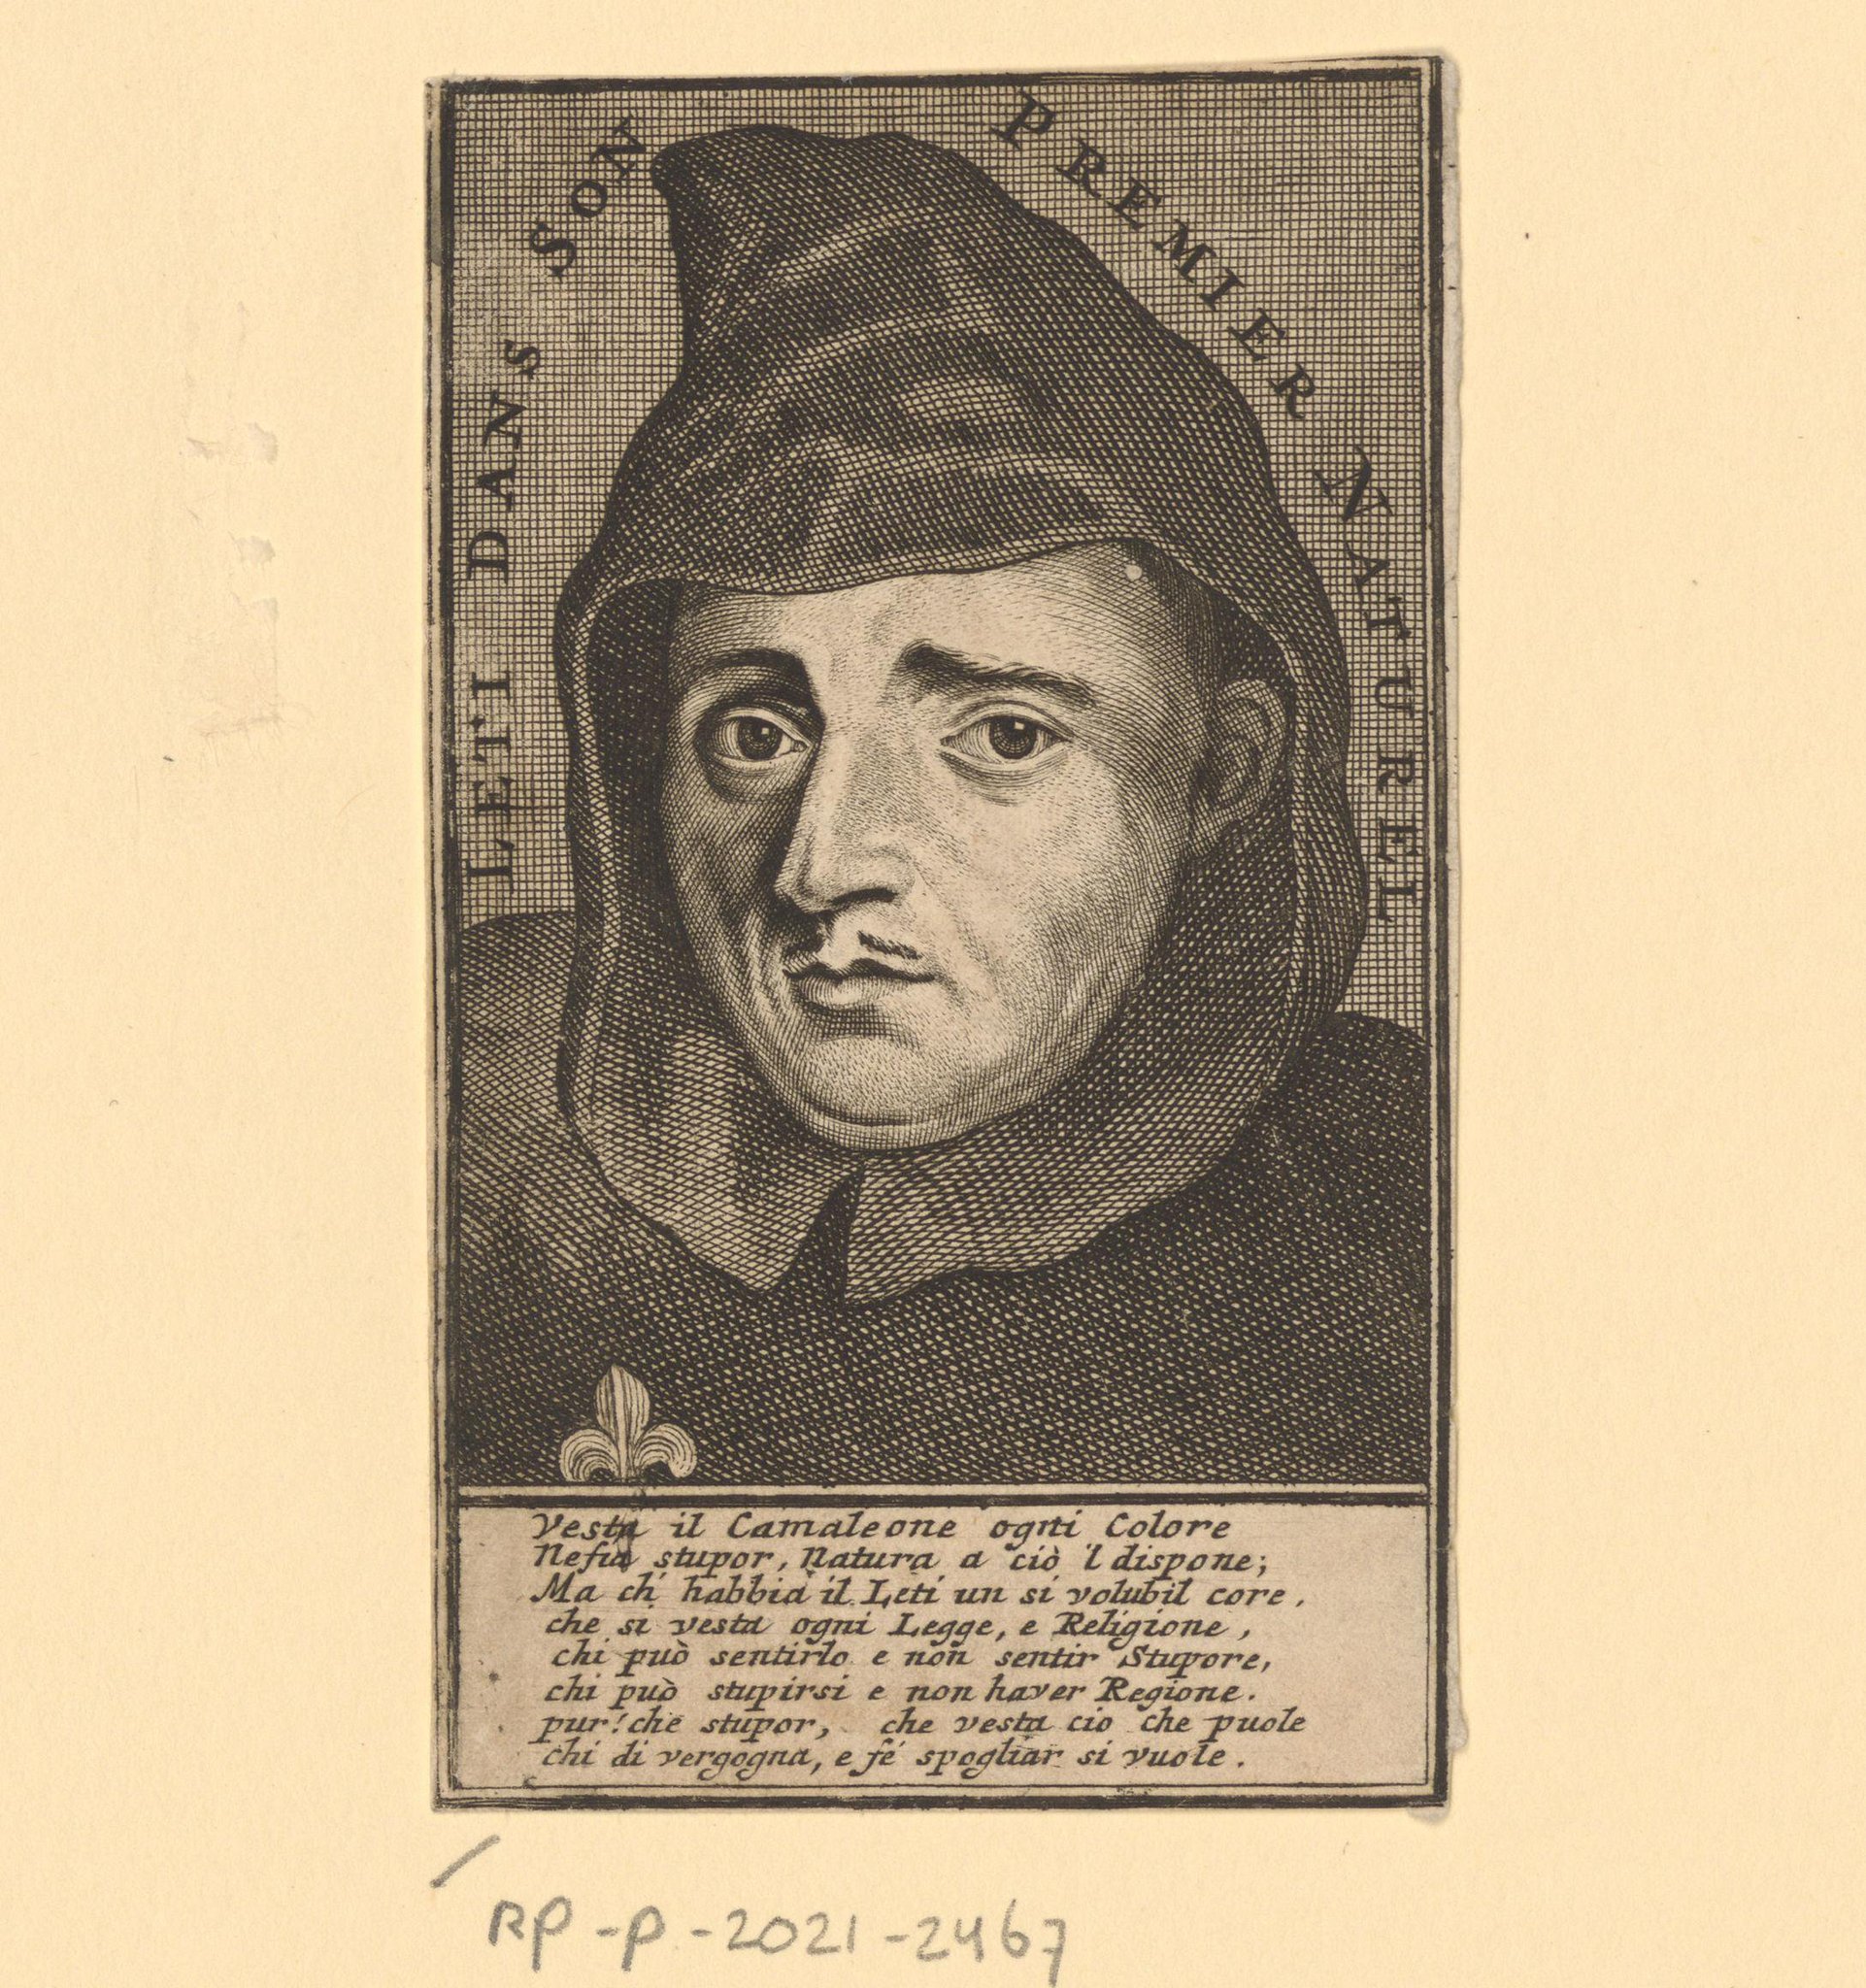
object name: print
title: Portret van Gregorio Leti met monnikskap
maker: Anonymous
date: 1697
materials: paper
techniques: engraving, etching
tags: amsterdam, history and archaeology (+ portrait of scholar, scientist), historical persons, portrait of a writer, monk(s), friar(s)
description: Prent waarschijnlijk uit: Leti, Gregorio. Critique historique, politique, morale, économique & comique sur les Lotteries (...). Amsterdam: s.n. [Chez les Amis de L'Auteur], 1697, dl. 1.